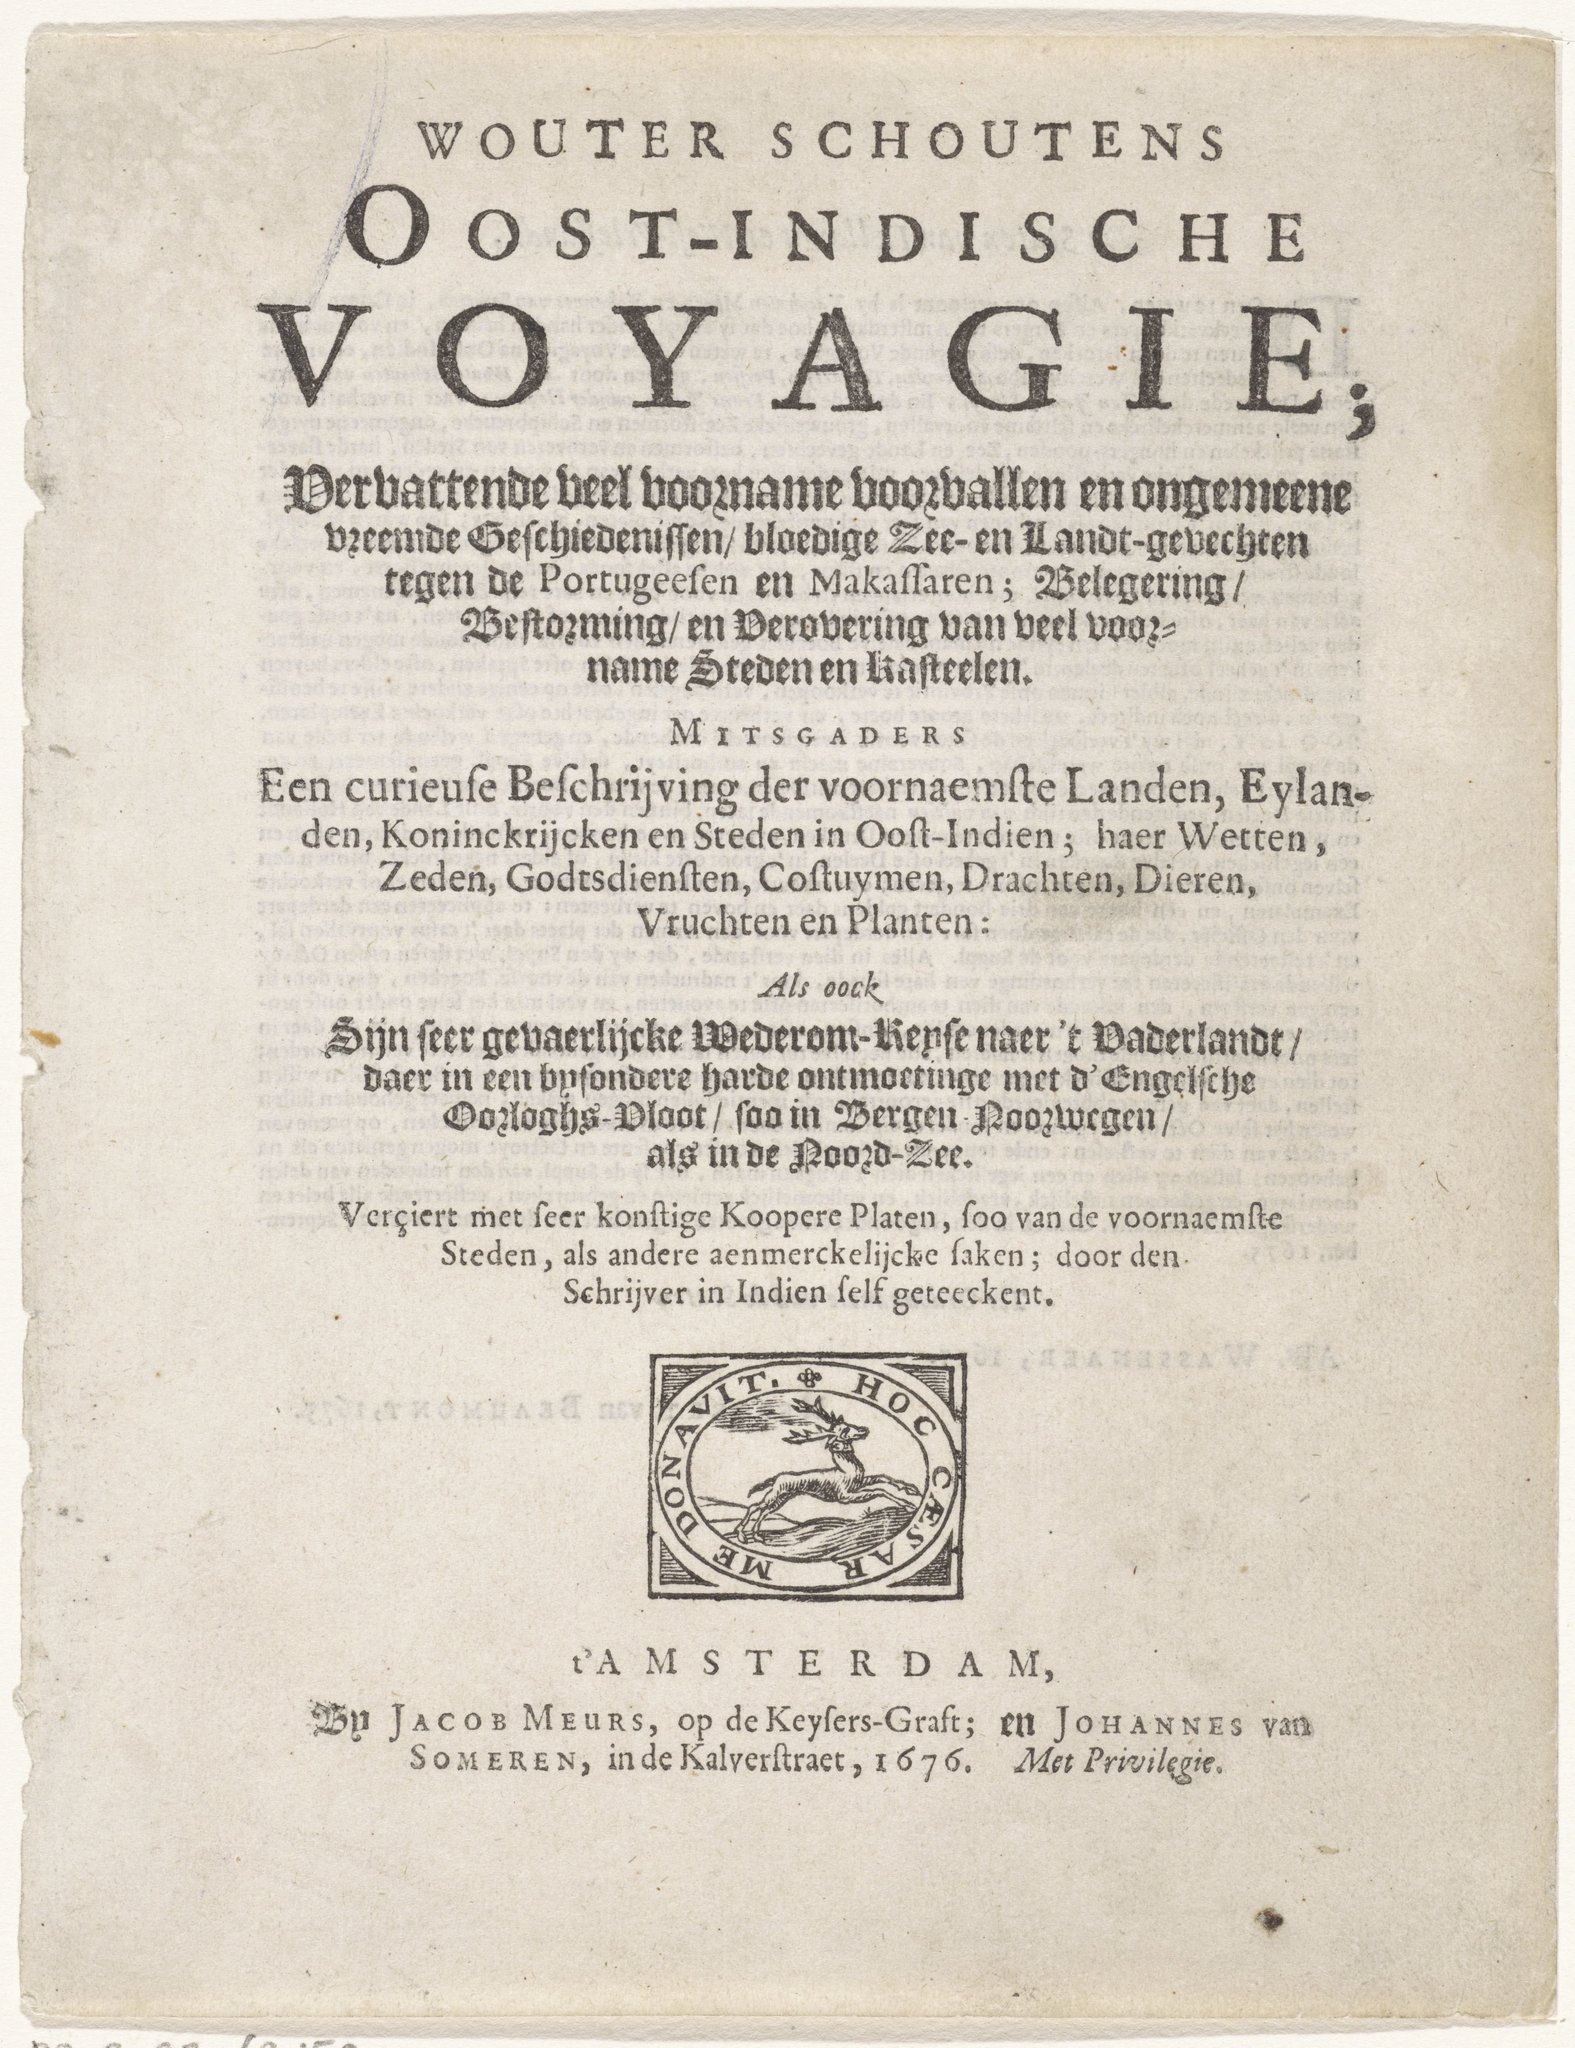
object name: titelblad, titelpagina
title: Titelpagina voor: Schoutens, Wouter. Oost-Indische voyagie (...), 1676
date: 1676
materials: paper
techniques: engraving, letterpress printing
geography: amsterdam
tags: title-page, device (trade-mark of printer or publisher)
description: Tekstblad met onderaan een drukkersmerk in de vorm van een hert op een heuvel met een Latijns motto eromheen. Verso een tekst door de privilegeverleners.